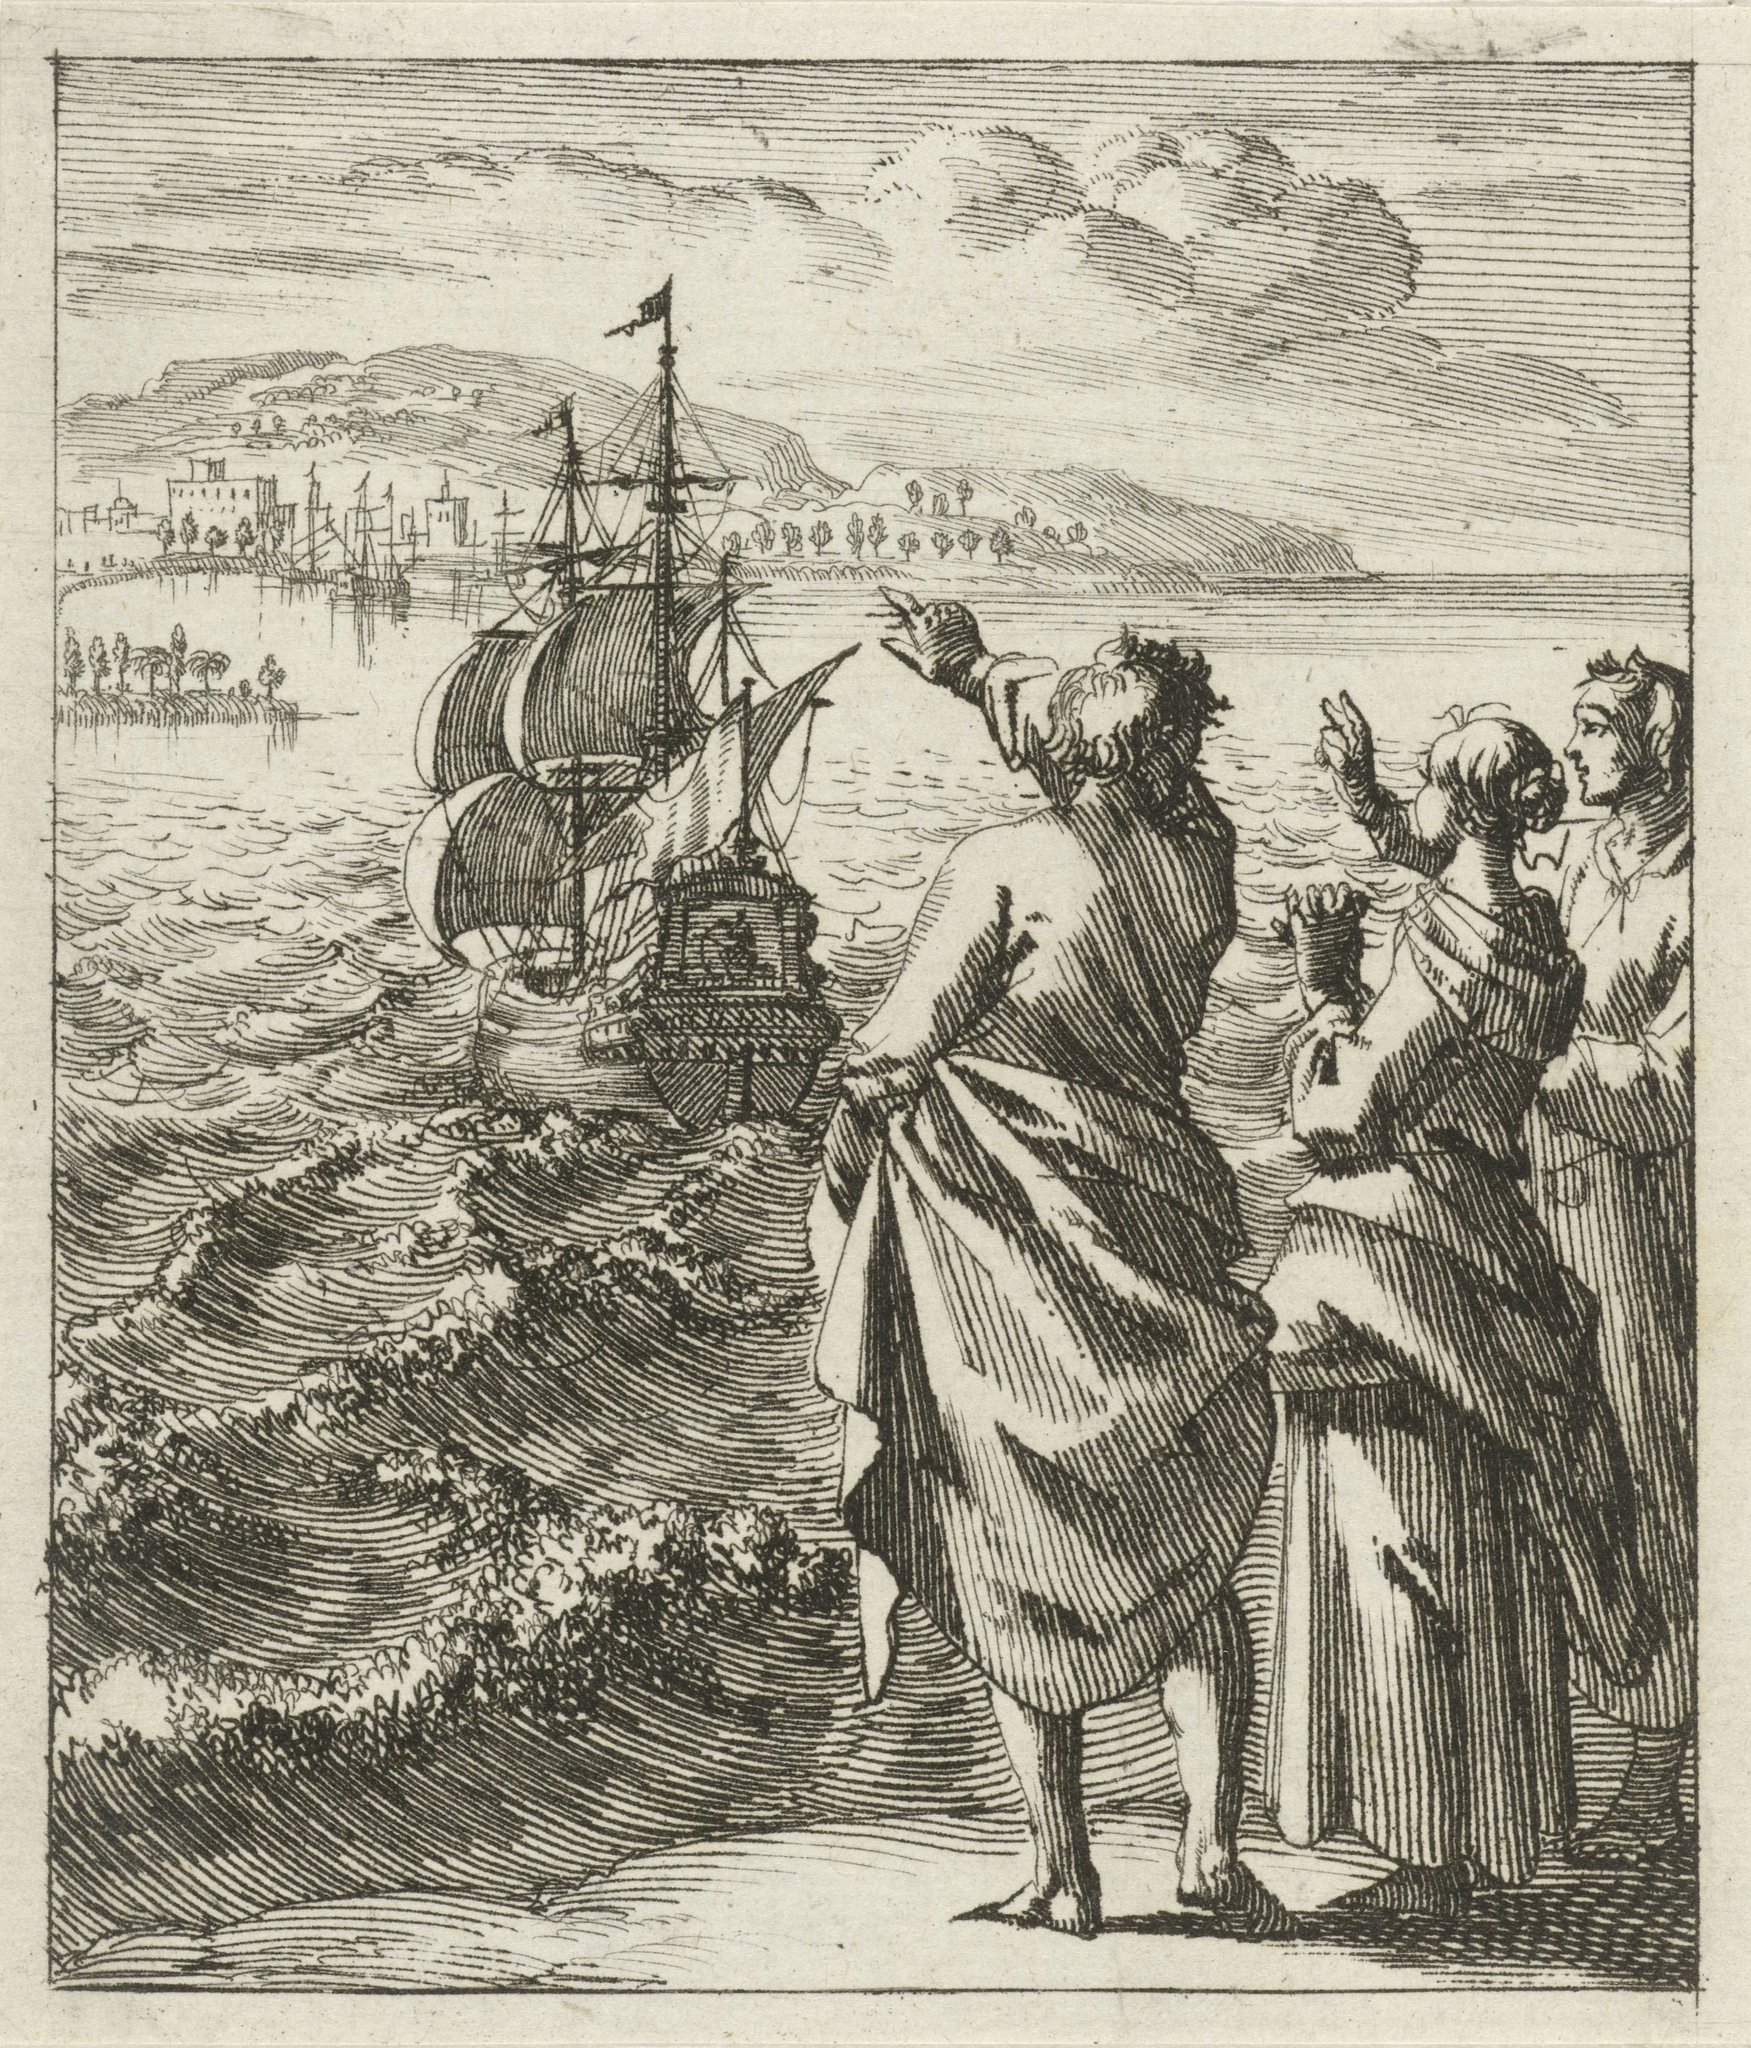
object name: print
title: Drie figuren zwaaien een zeilschip uit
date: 1689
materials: paper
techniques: etching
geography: amsterdam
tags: sailing-ship, sailing-boat, waving farewell ~ departure on a journey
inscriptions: collector's mark: Lugt 2228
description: Illustratie uit: Huygen, Pieter. De beginselen van Gods koninkryk in den mensch uitgedrukt in zinnebeelden. Amsterdam: wed. Arentsz. Pieter (II), 1689, p. 56.